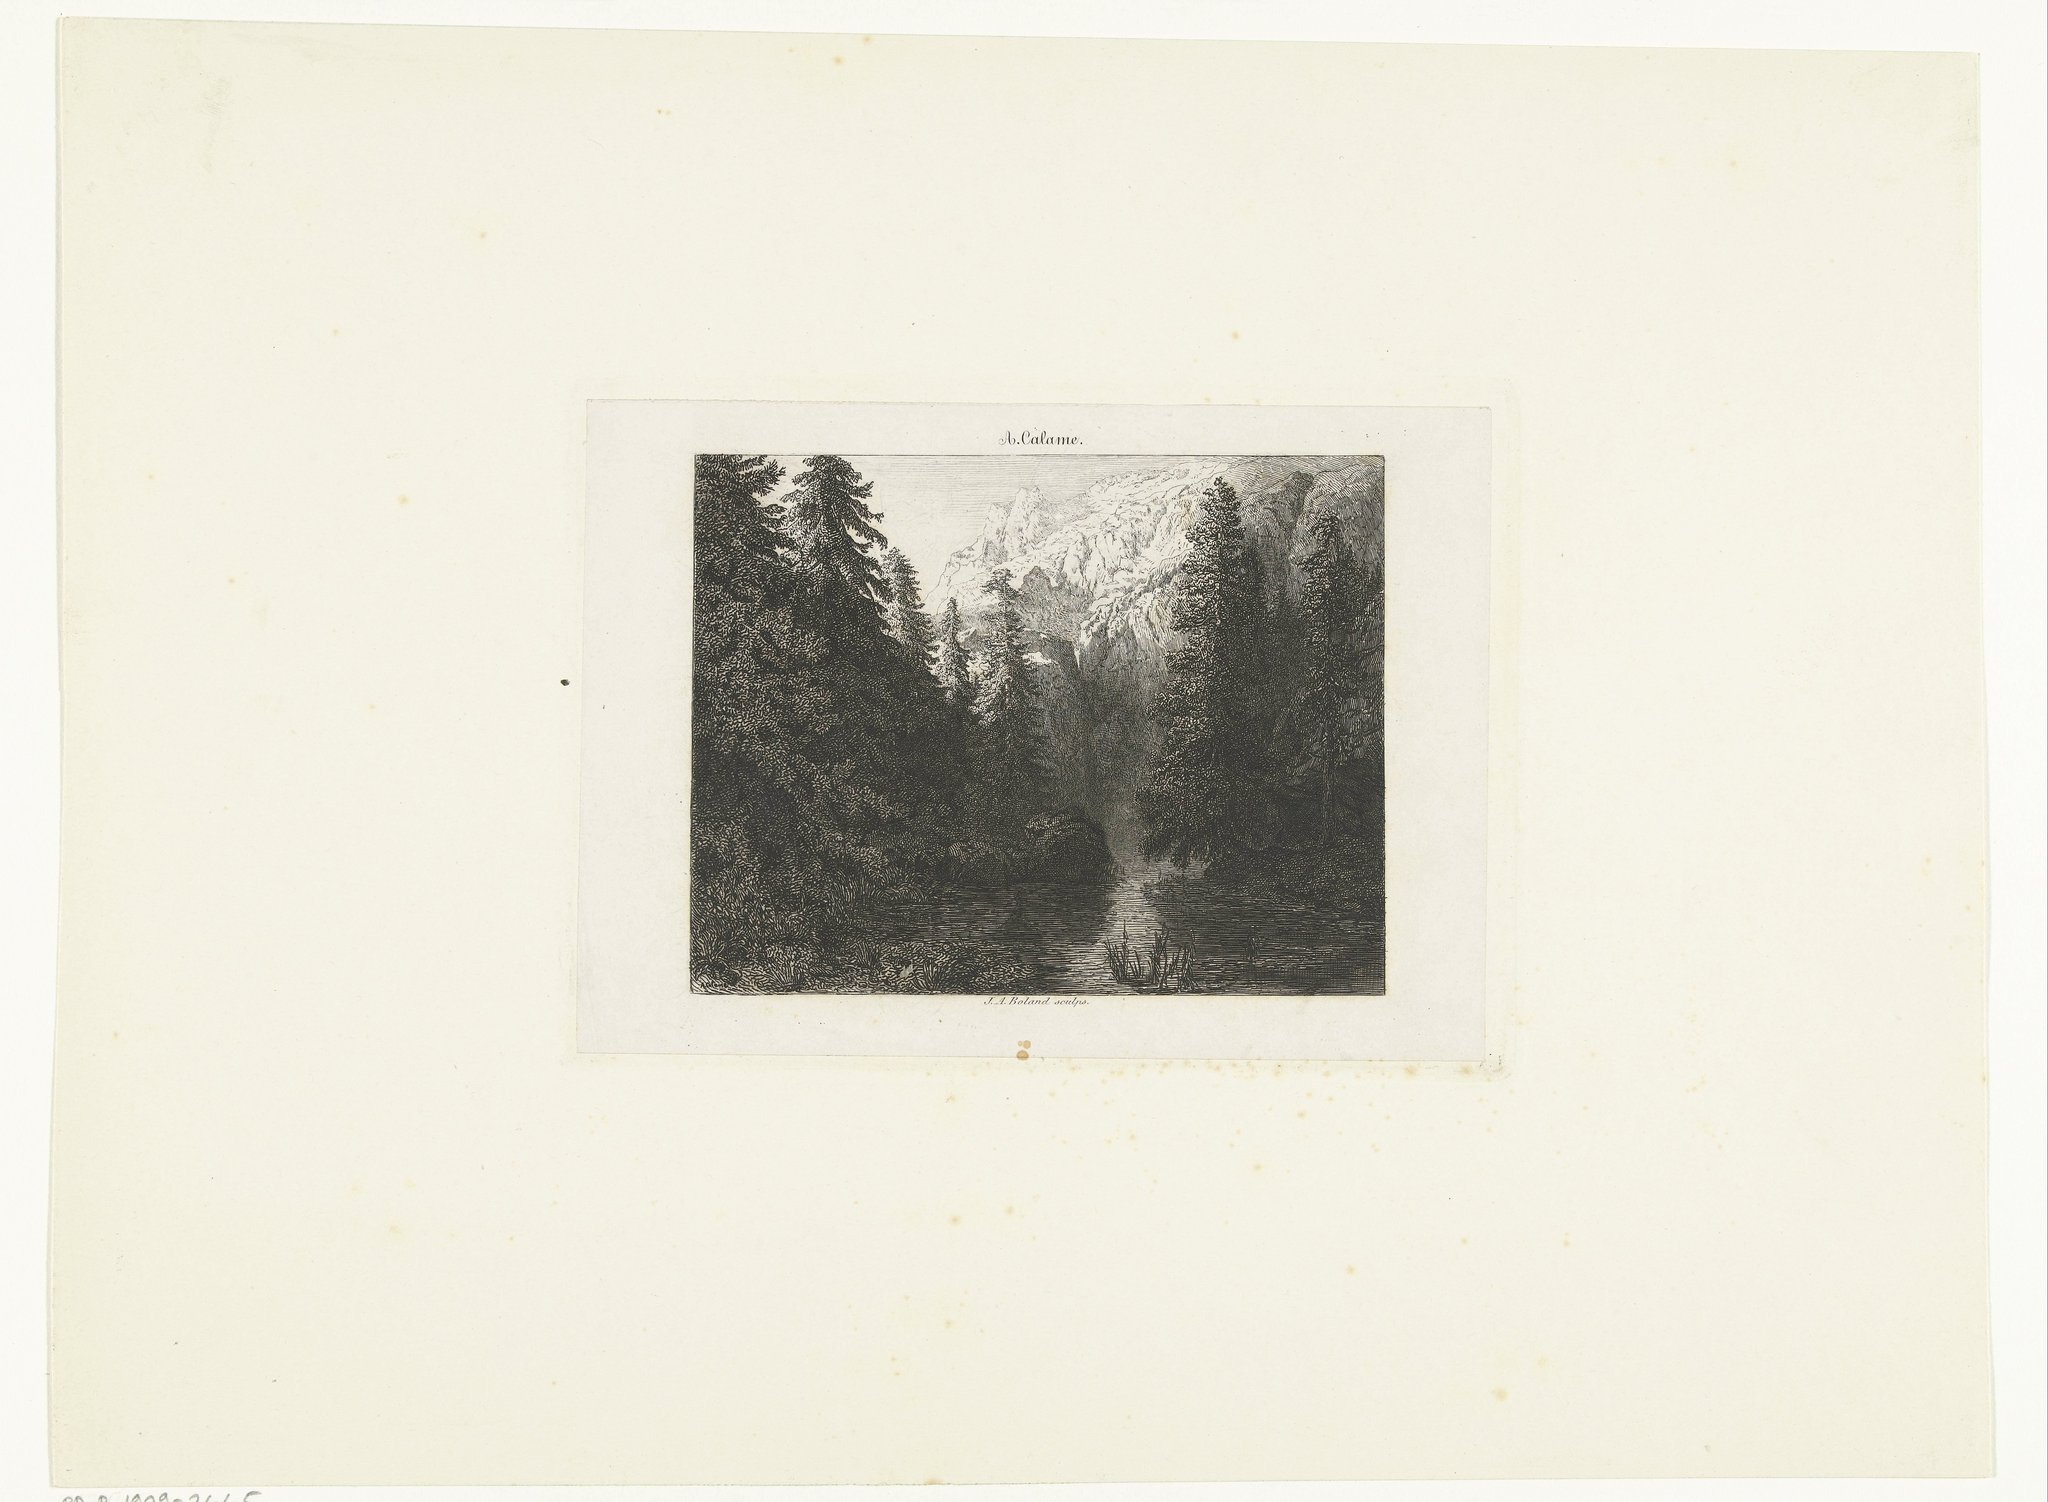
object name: print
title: Berglandschap met meertje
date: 1860-1900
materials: paper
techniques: etching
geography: amsterdam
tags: pond, pool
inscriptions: collector's mark: Lugt 2165